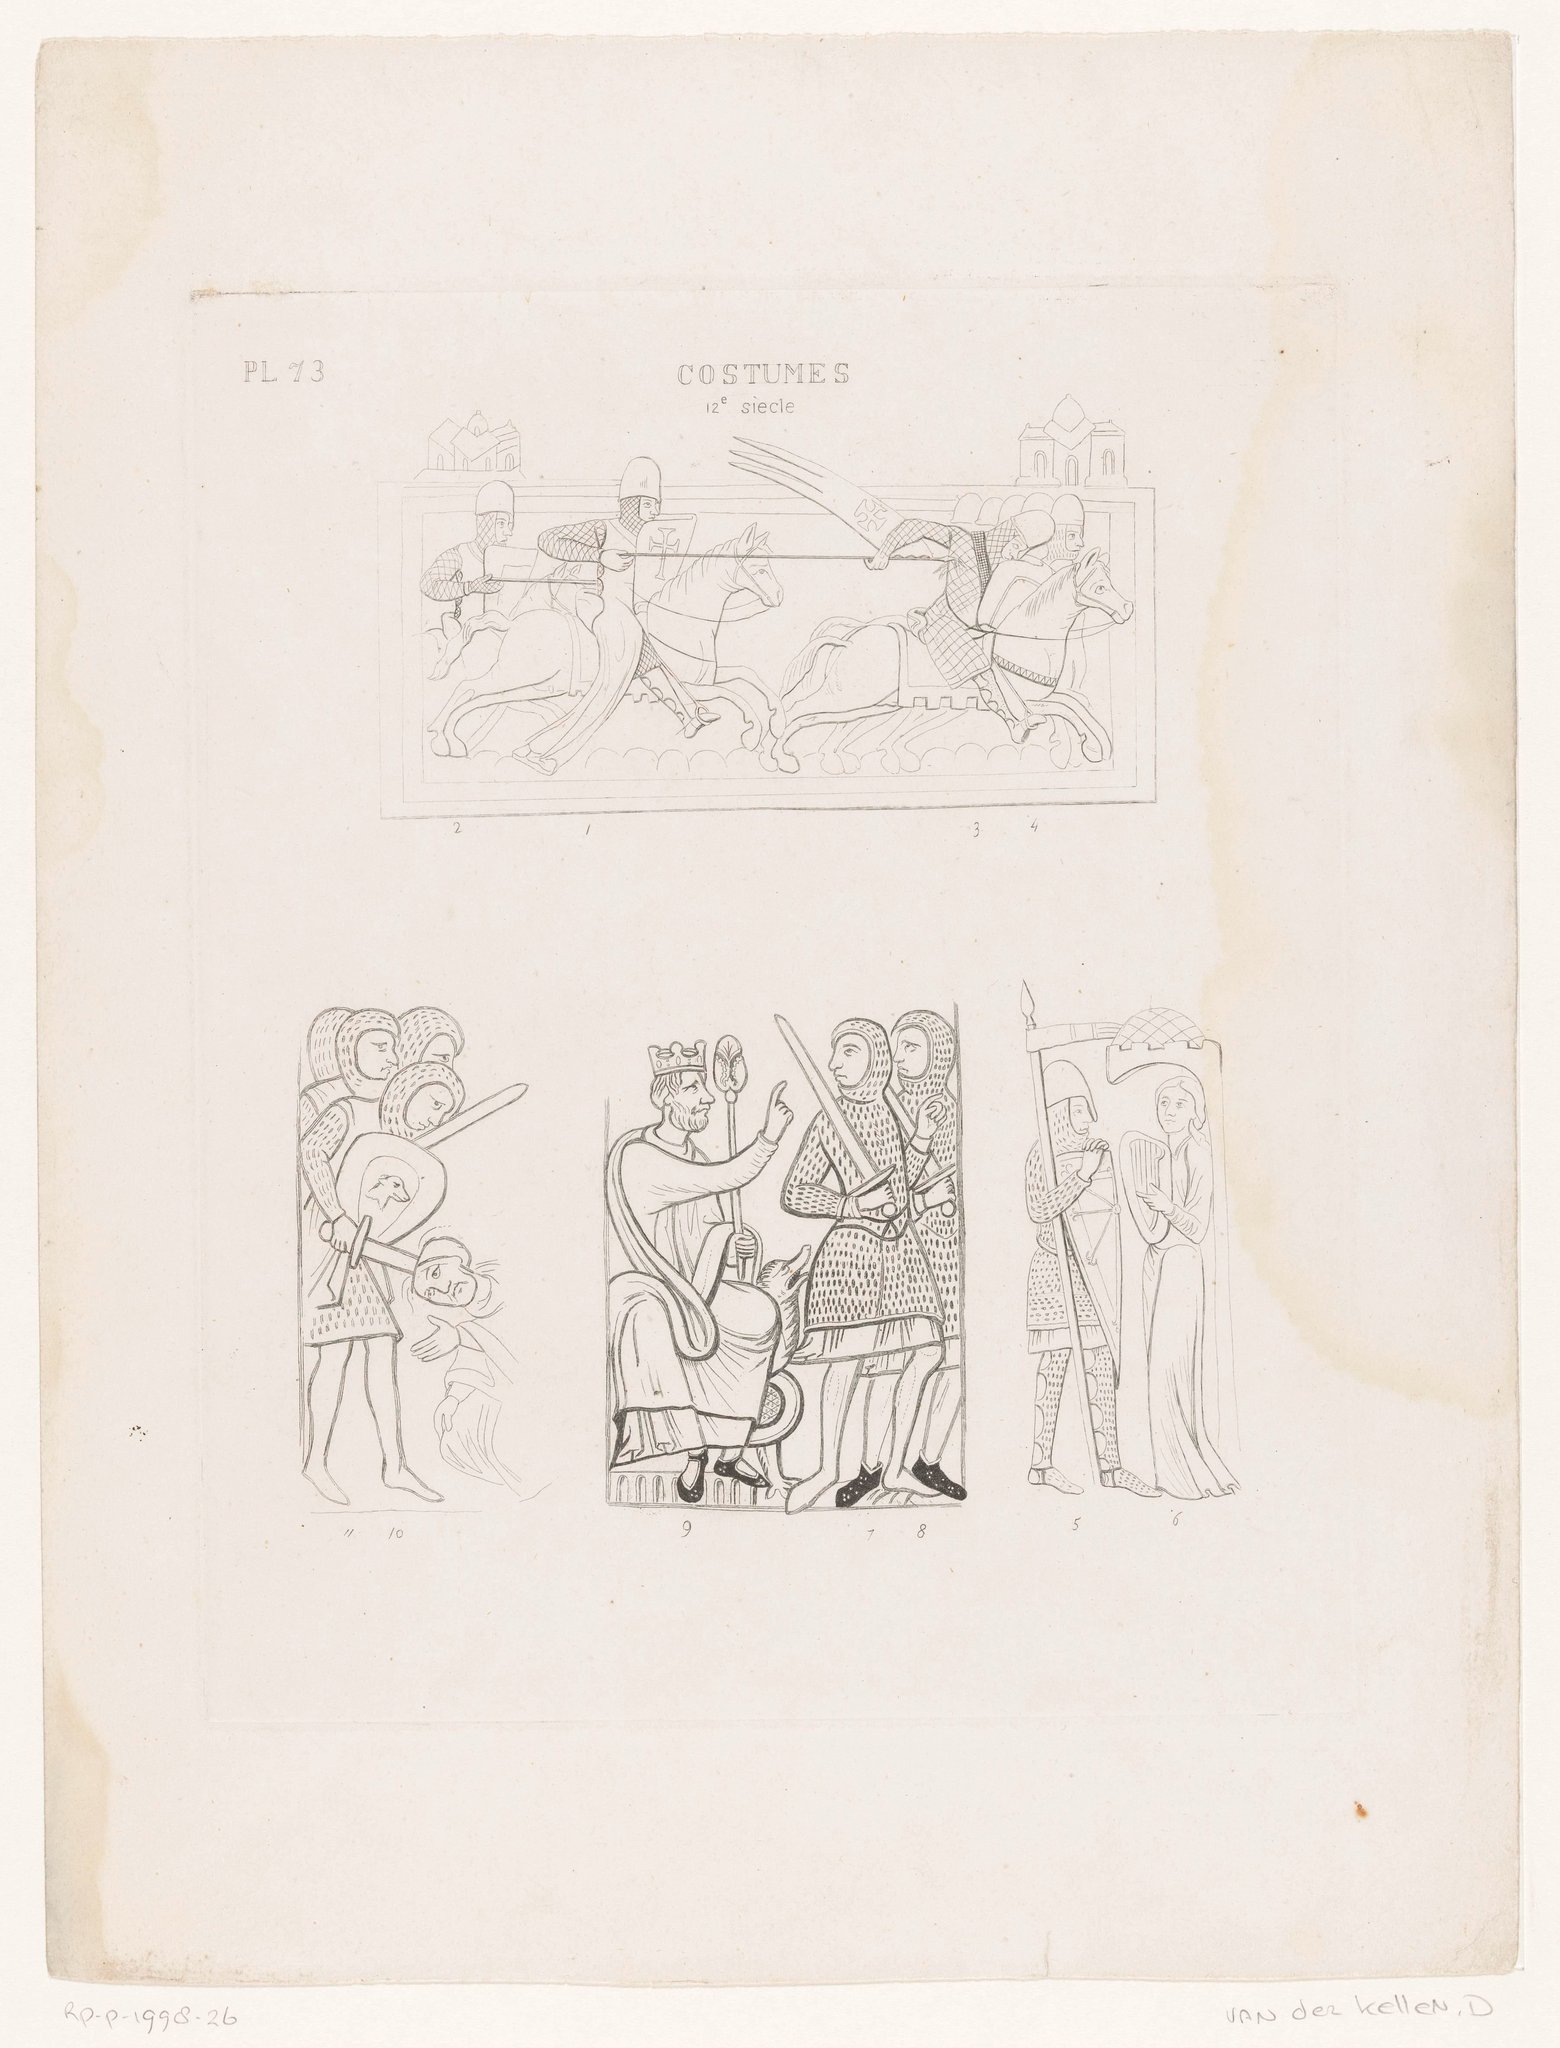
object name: book illustration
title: Costumes 12e siecle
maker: david van der kellen (1804-1879)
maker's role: die cutter, draughtsman, print maker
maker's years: 1804-1879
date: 1865-1878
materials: paper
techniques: etching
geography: netherlands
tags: clothes, costume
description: Ridderkostuums uit de twaalfde eeuw, bovenaan een steekspel.